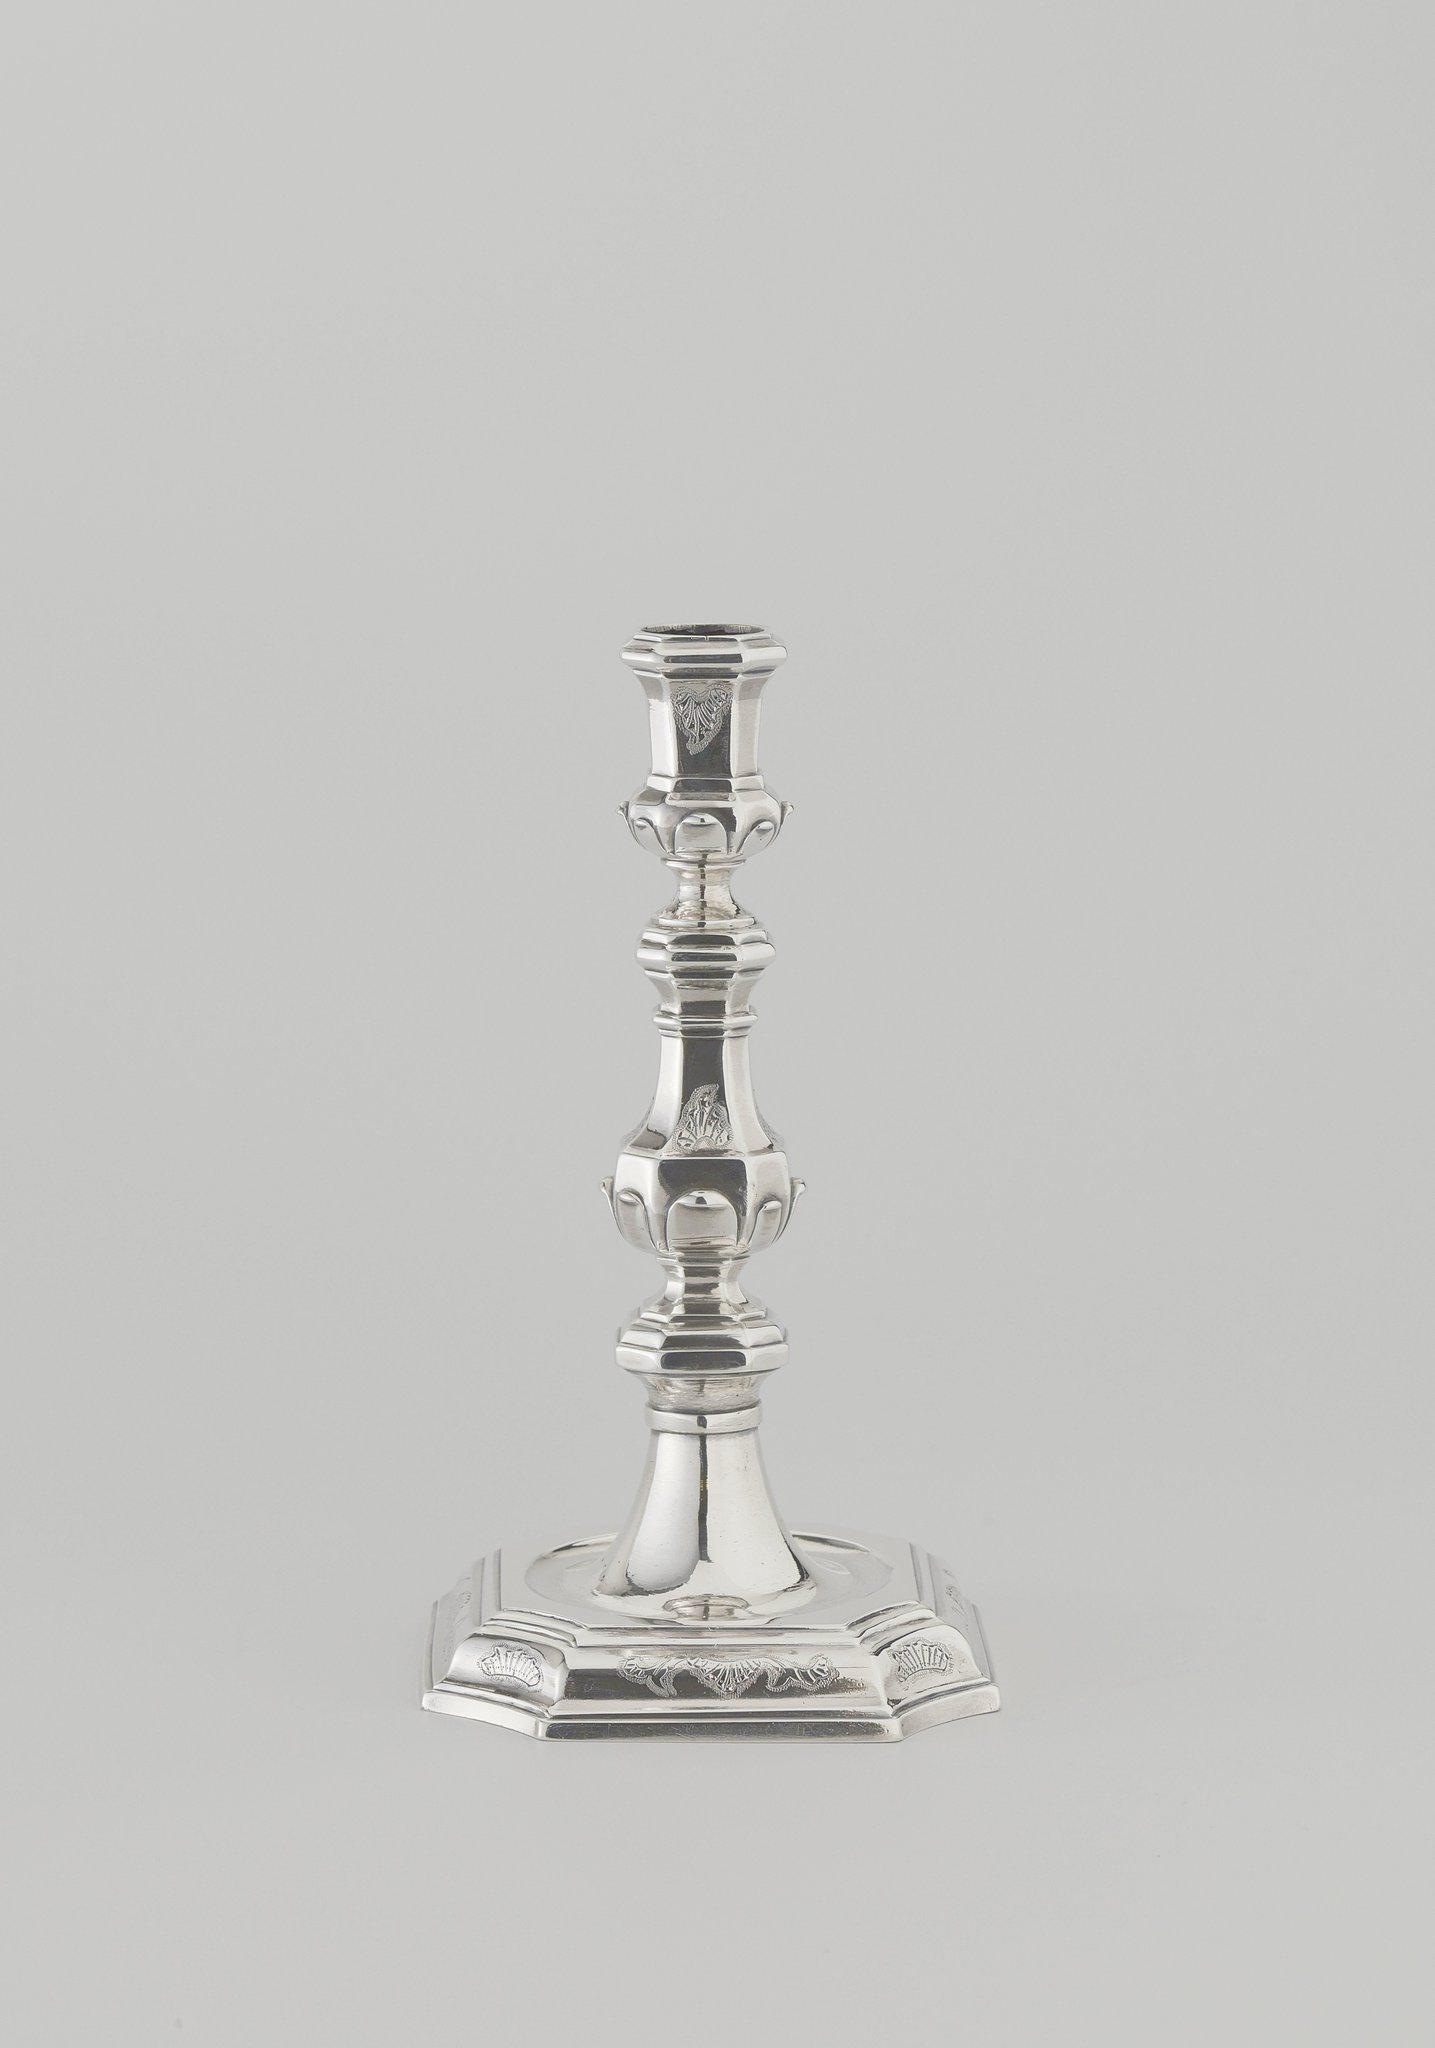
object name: candlestick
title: Kandelaar van zilver met achthoekige voet en achthoekige balustervormige stam met kaarsenhouder. Gegraveerd met rocaillemotieven.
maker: jacobus johannes dreux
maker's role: silversmith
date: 1752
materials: silver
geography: rotterdam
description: Kandelaar van zilver. De voet is achthoekig en in de vlakke bovenzijde bevindt zich een ronde verdieping. De balustervormige stam is achthoekig evenals de kaarsenhouder. Voet, stam en kaarsenhouder zijn gegraveerd met rocaille-motieven.